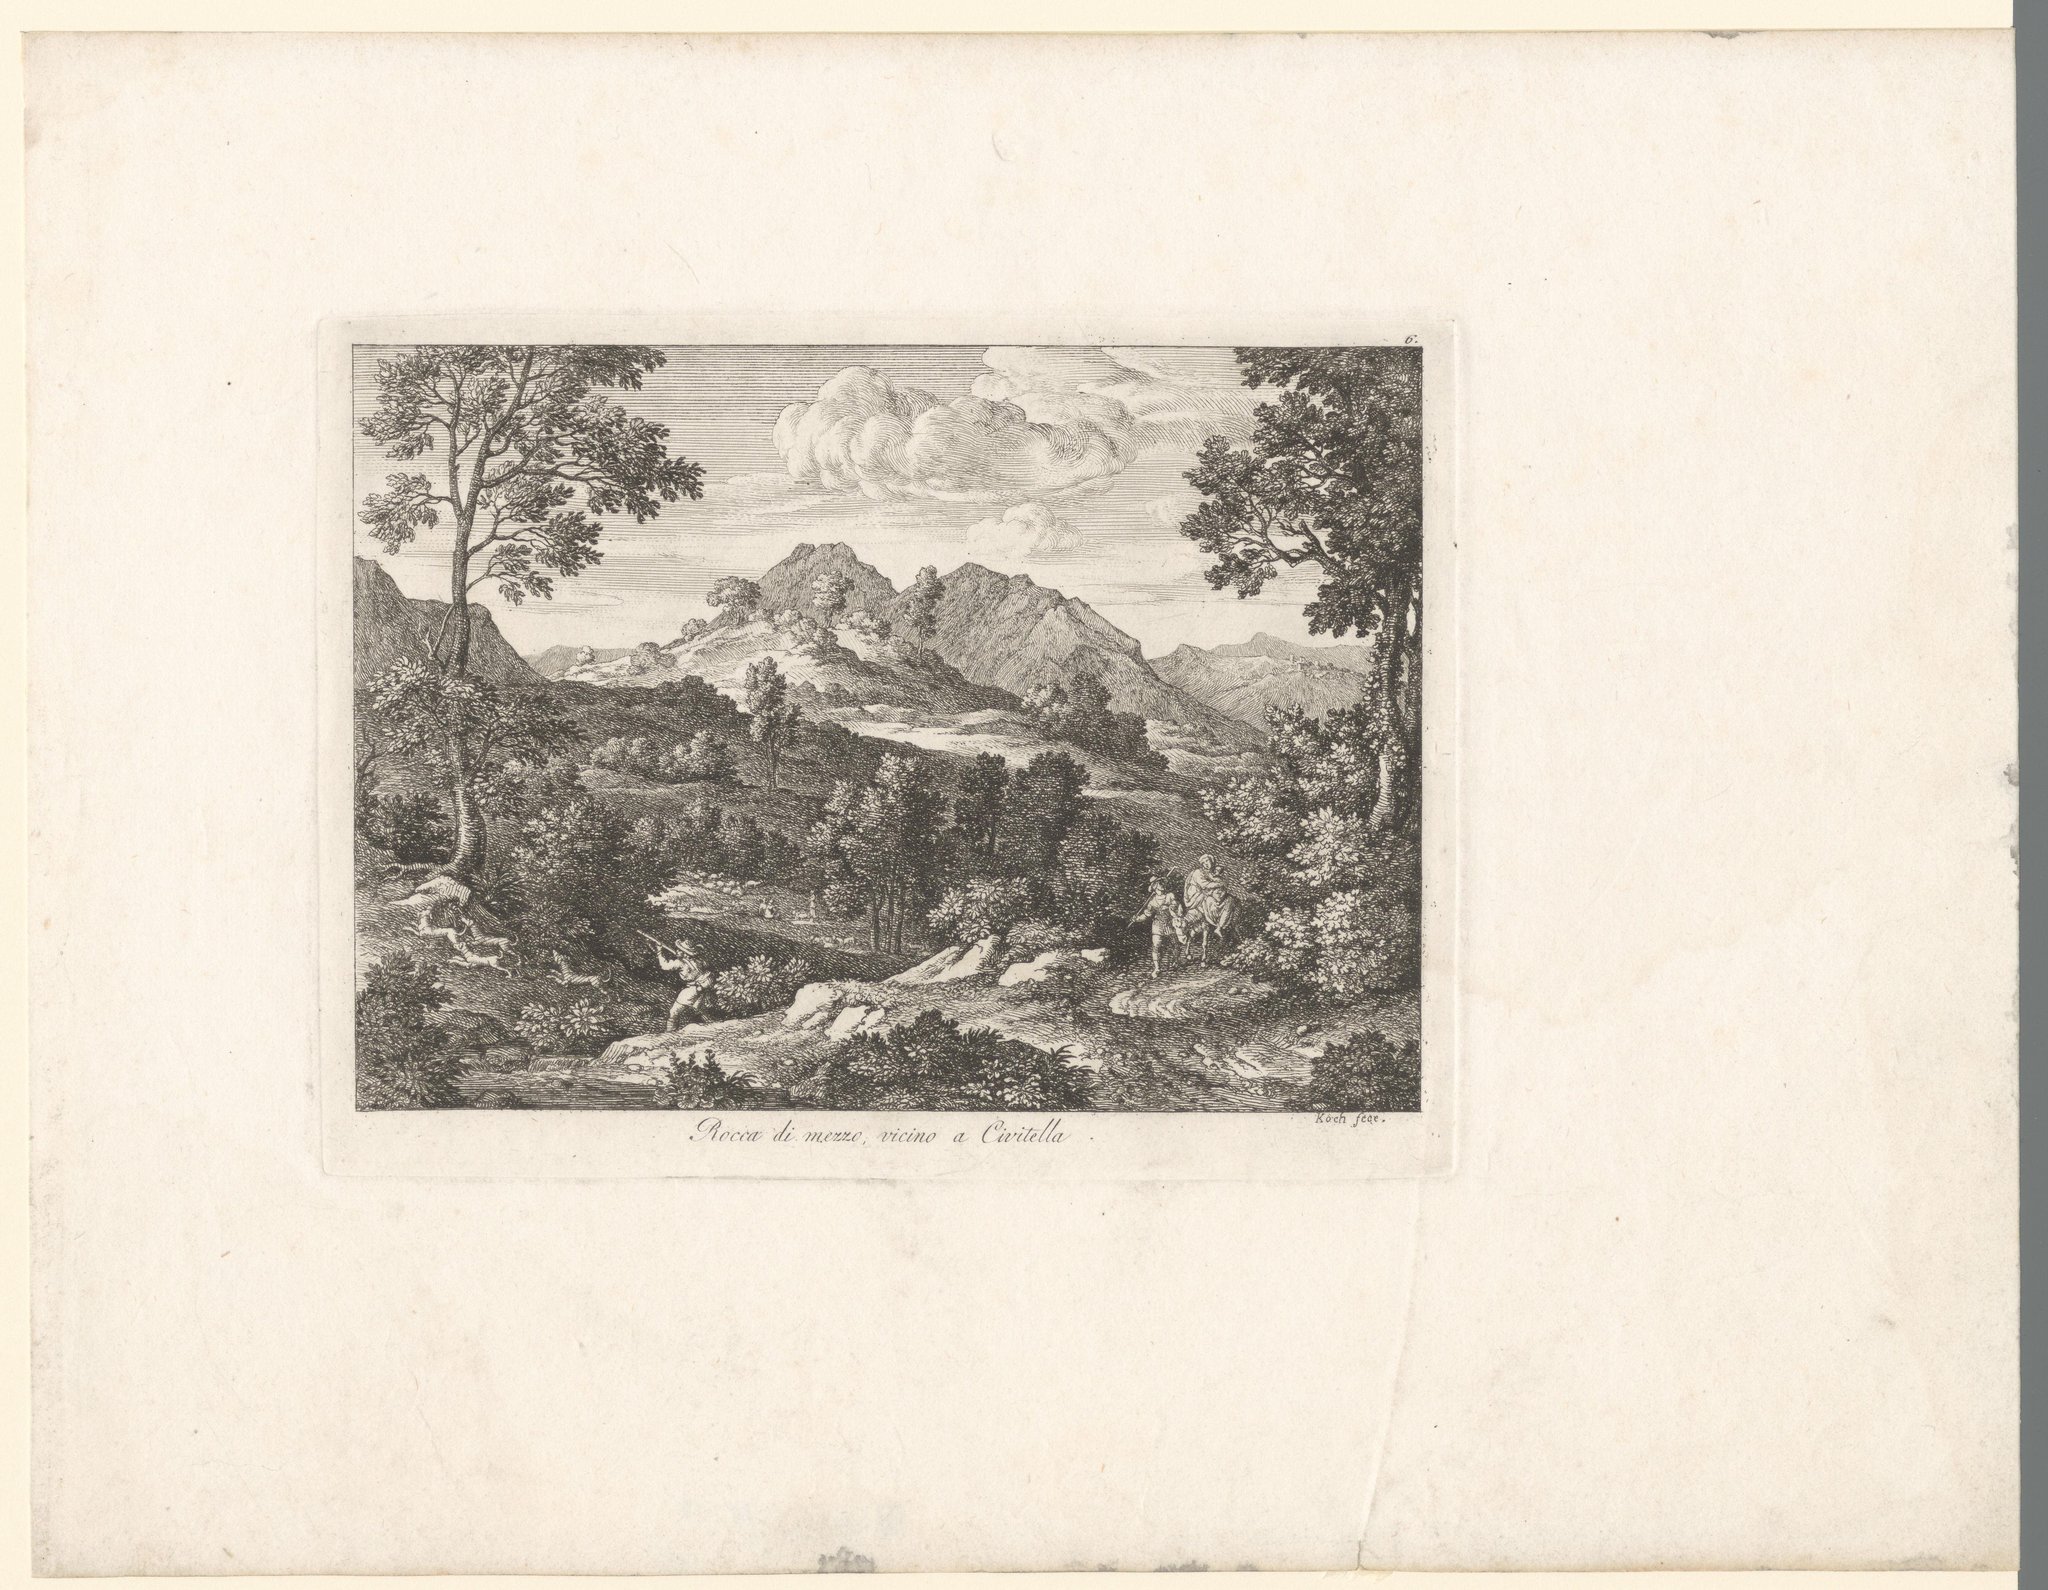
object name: print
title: Rotsachtig landschap met jagers en zicht op Rocca di Mezzo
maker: joseph anton koch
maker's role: draughtsman, painter, print maker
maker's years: 1768-1839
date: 1803-1805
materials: paper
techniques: etching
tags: city-view, and landscape with man-made constructions, low hill country, hunters hunting (n.b.: in 1988-1990 this notation denoted the concept of 43c11421 'hunters resting during the hunt'), 'en route', traveller under way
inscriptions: number: ‘6’, collector's mark: Lugt 2228, collector's mark: Lugt 2760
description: Deze prenten komen mogelijk uit de collectie van Robert von Langer (1783-1846) uit München.